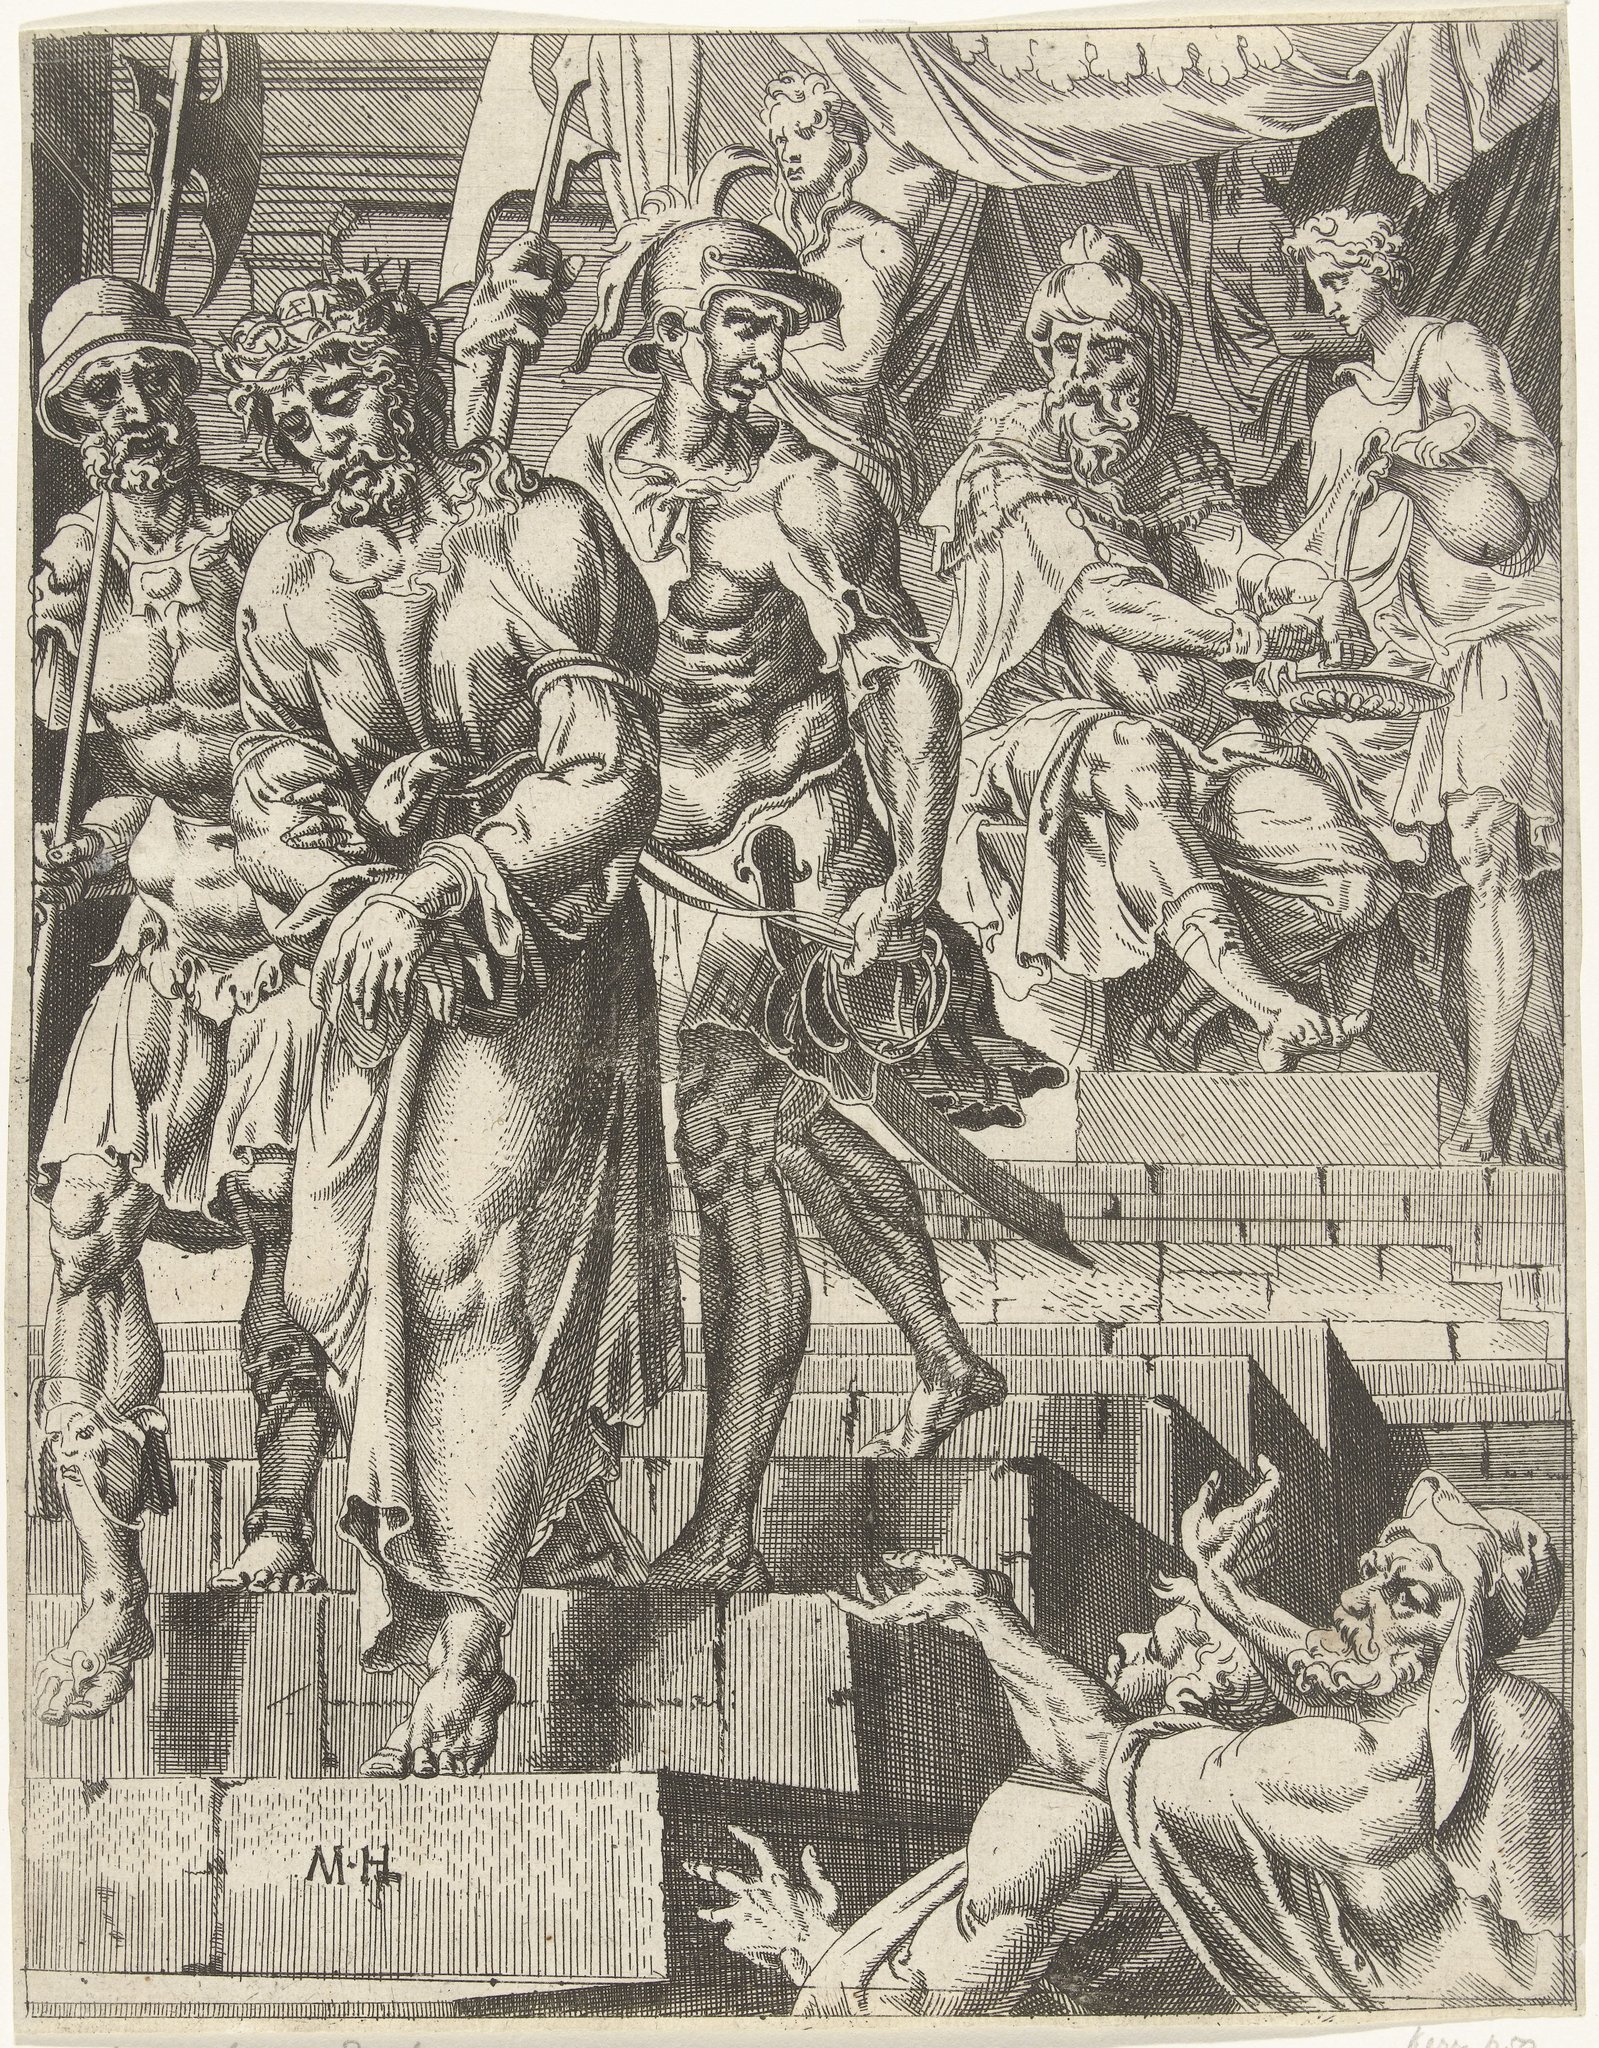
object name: print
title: Pilatus wast zijn handen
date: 1548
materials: paper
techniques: etching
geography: haarlem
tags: pilate washing his hands (in innocence)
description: Christus wordt ter dood veroordeeld en afgevoerd. Pilatus wast zijn handen in onschuld. De prent is deel van een dertigdelige serie met prenten over de zondeval en Christus' passie.